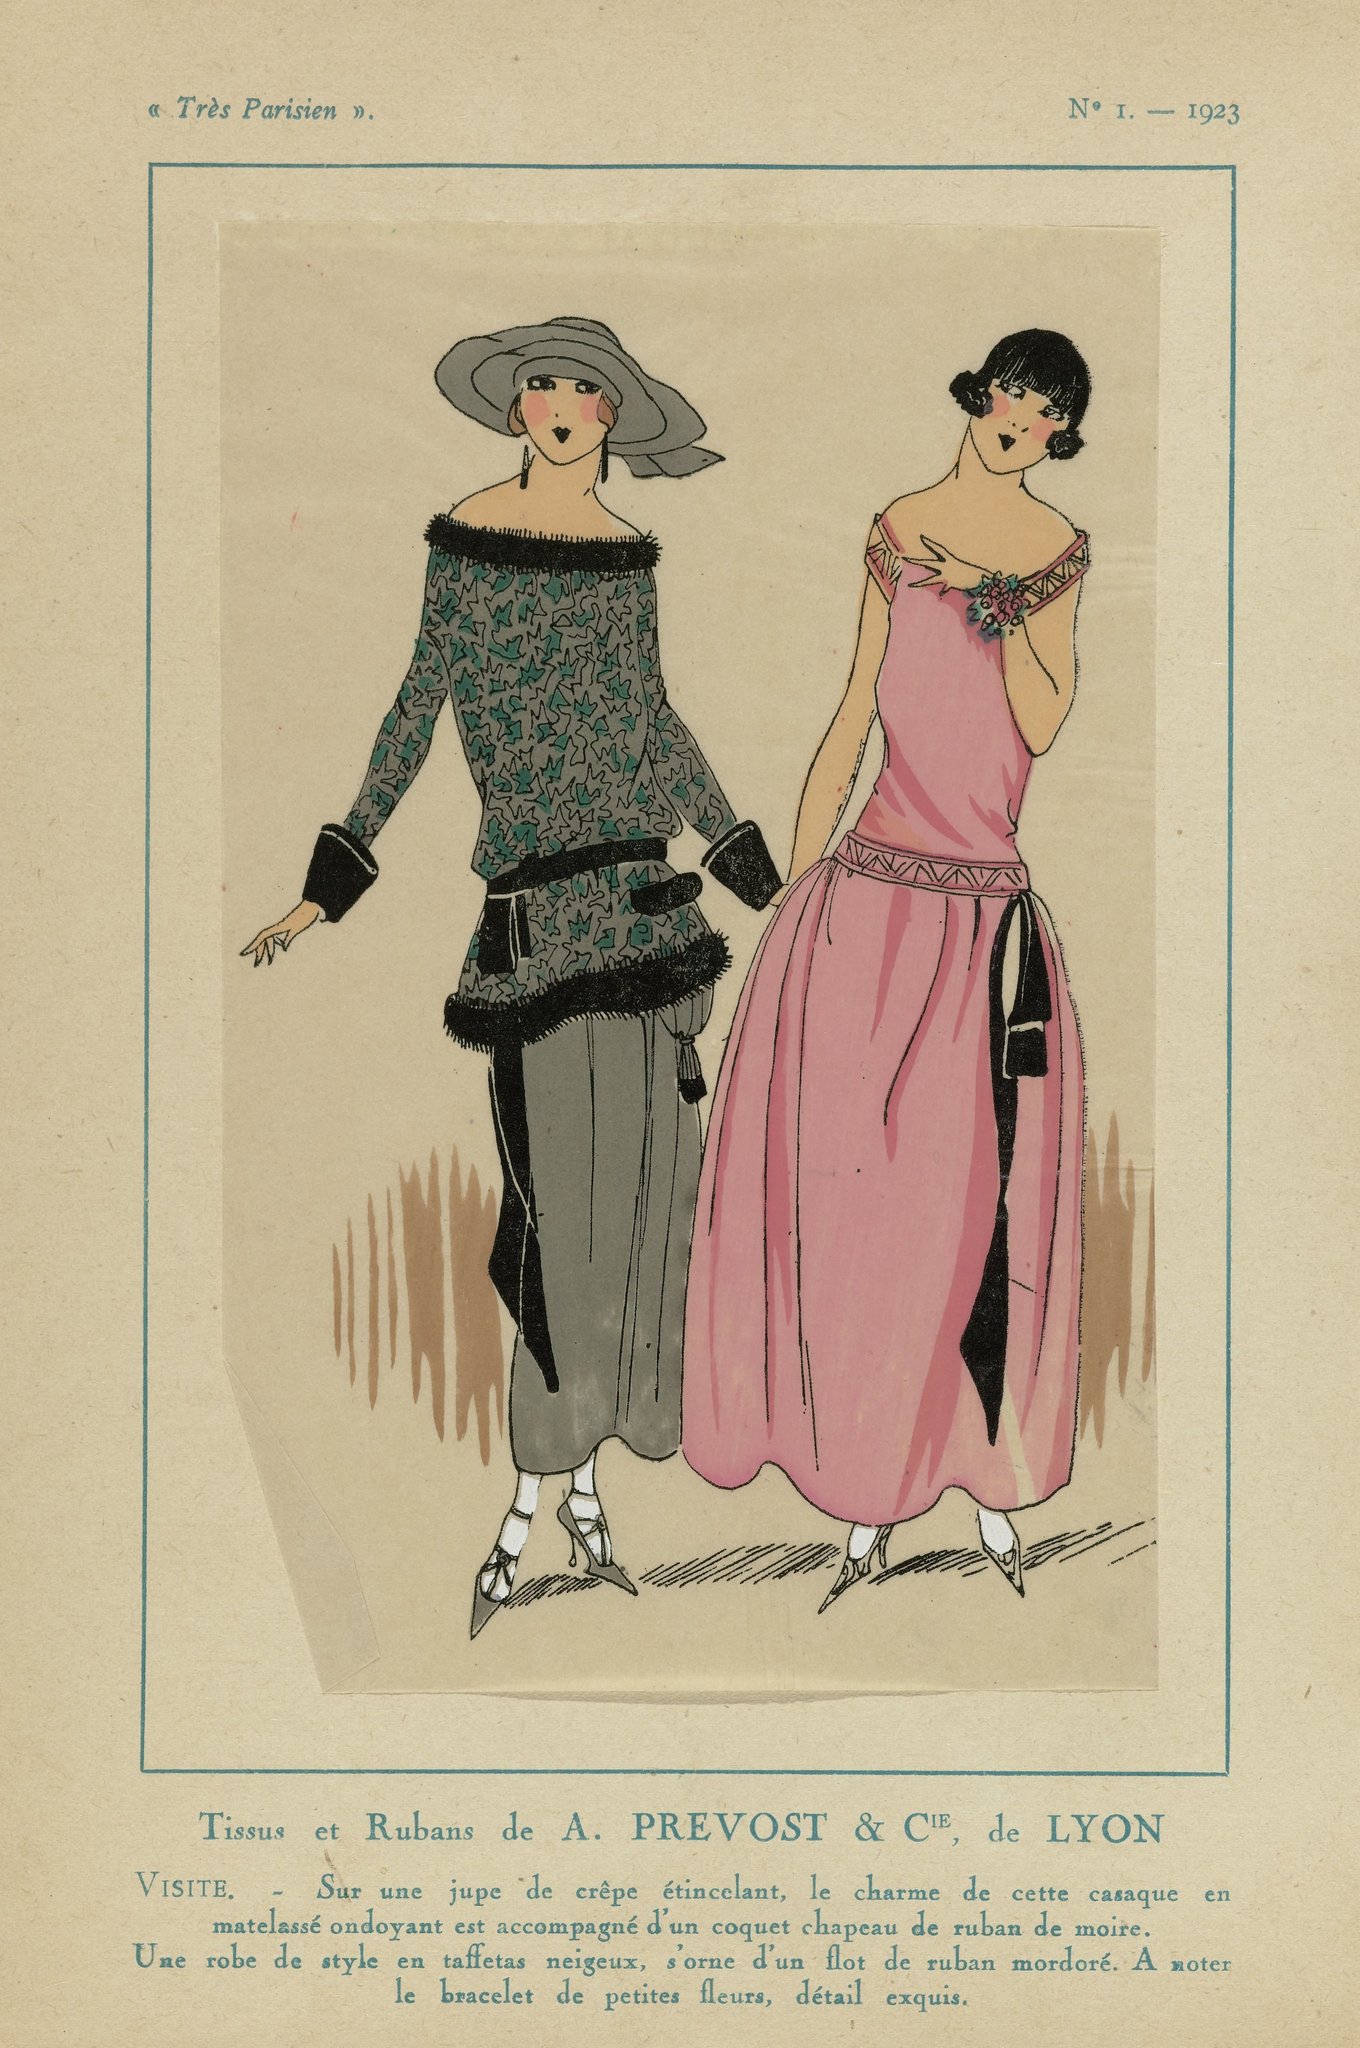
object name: fashion print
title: Très Parisien, 1923, No 1: Tissus et Rubans de A. PREVOST ...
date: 1923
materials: paper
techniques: hand coloring, letterpress printing, lithography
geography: paris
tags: flowers, border, ribbon, braid (+ women's clothes), dress, gown (robe de style) (+ women's clothes), fashion plates, head-gear: hat (+ women's clothes), bracelet, wristlet (+ women's clothes)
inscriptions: caption: ‘Tissus et Rubans de A. Prevost & Cie, de Lyon / VISITE. - Sur une jupe de crêpe étincelant, le charme de cette casaque en matelassé ondoyant est accompagné d'un coquet chapeau de ruban de moire. Une robe de style en taffetas neigeux, s'orne d'un flot de ruban mordoré. A noter le bracelet de petites fleurs, d'etail exquis.’, title: ‘Très Parisien / No 1. - 1923’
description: Casaque op een rok van glanzende crêpe met bijpassende hoed; 'robe de style' van tafzijde. Prent uit het modetijdschrift Très Parisien (1920-1936).